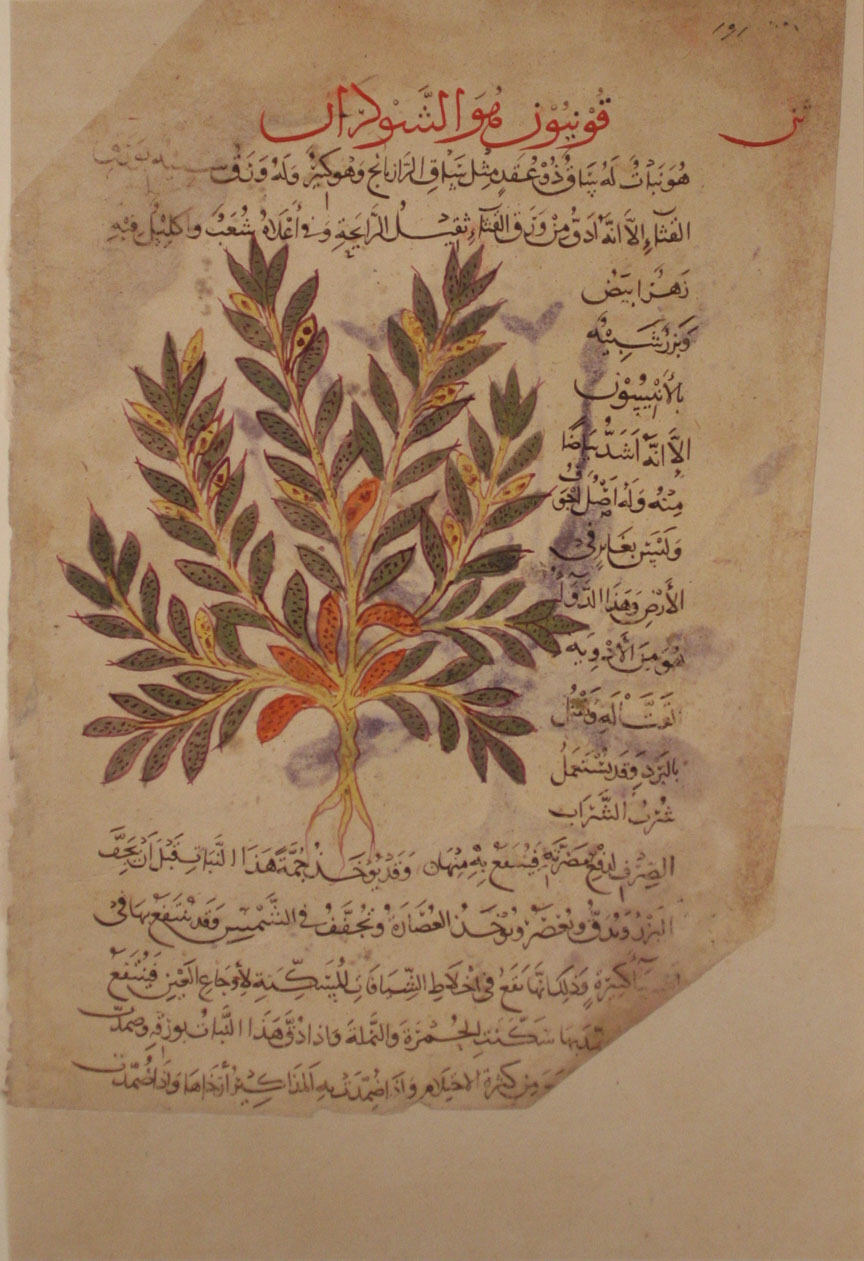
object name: folio from an illustrated manuscript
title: Folio from the De Materia Medica of Dioscorides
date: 1201-1300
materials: paper, watercolor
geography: iraq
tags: arabic,plants